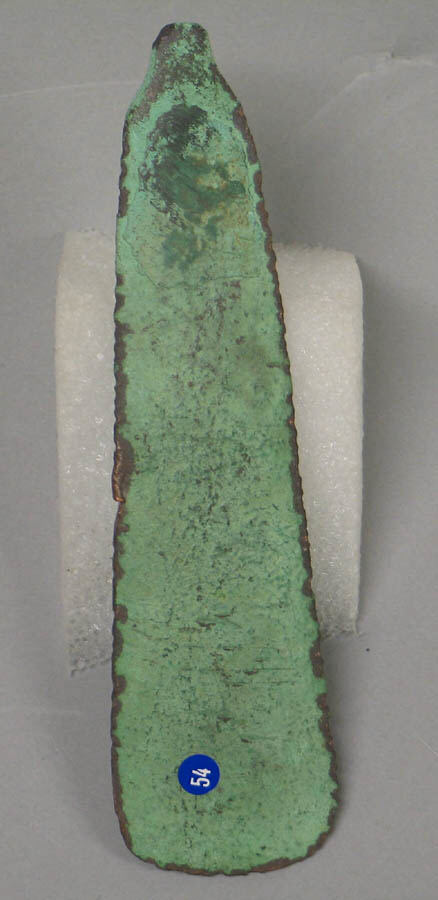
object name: ax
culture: indian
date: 1500-500 BCE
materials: copper